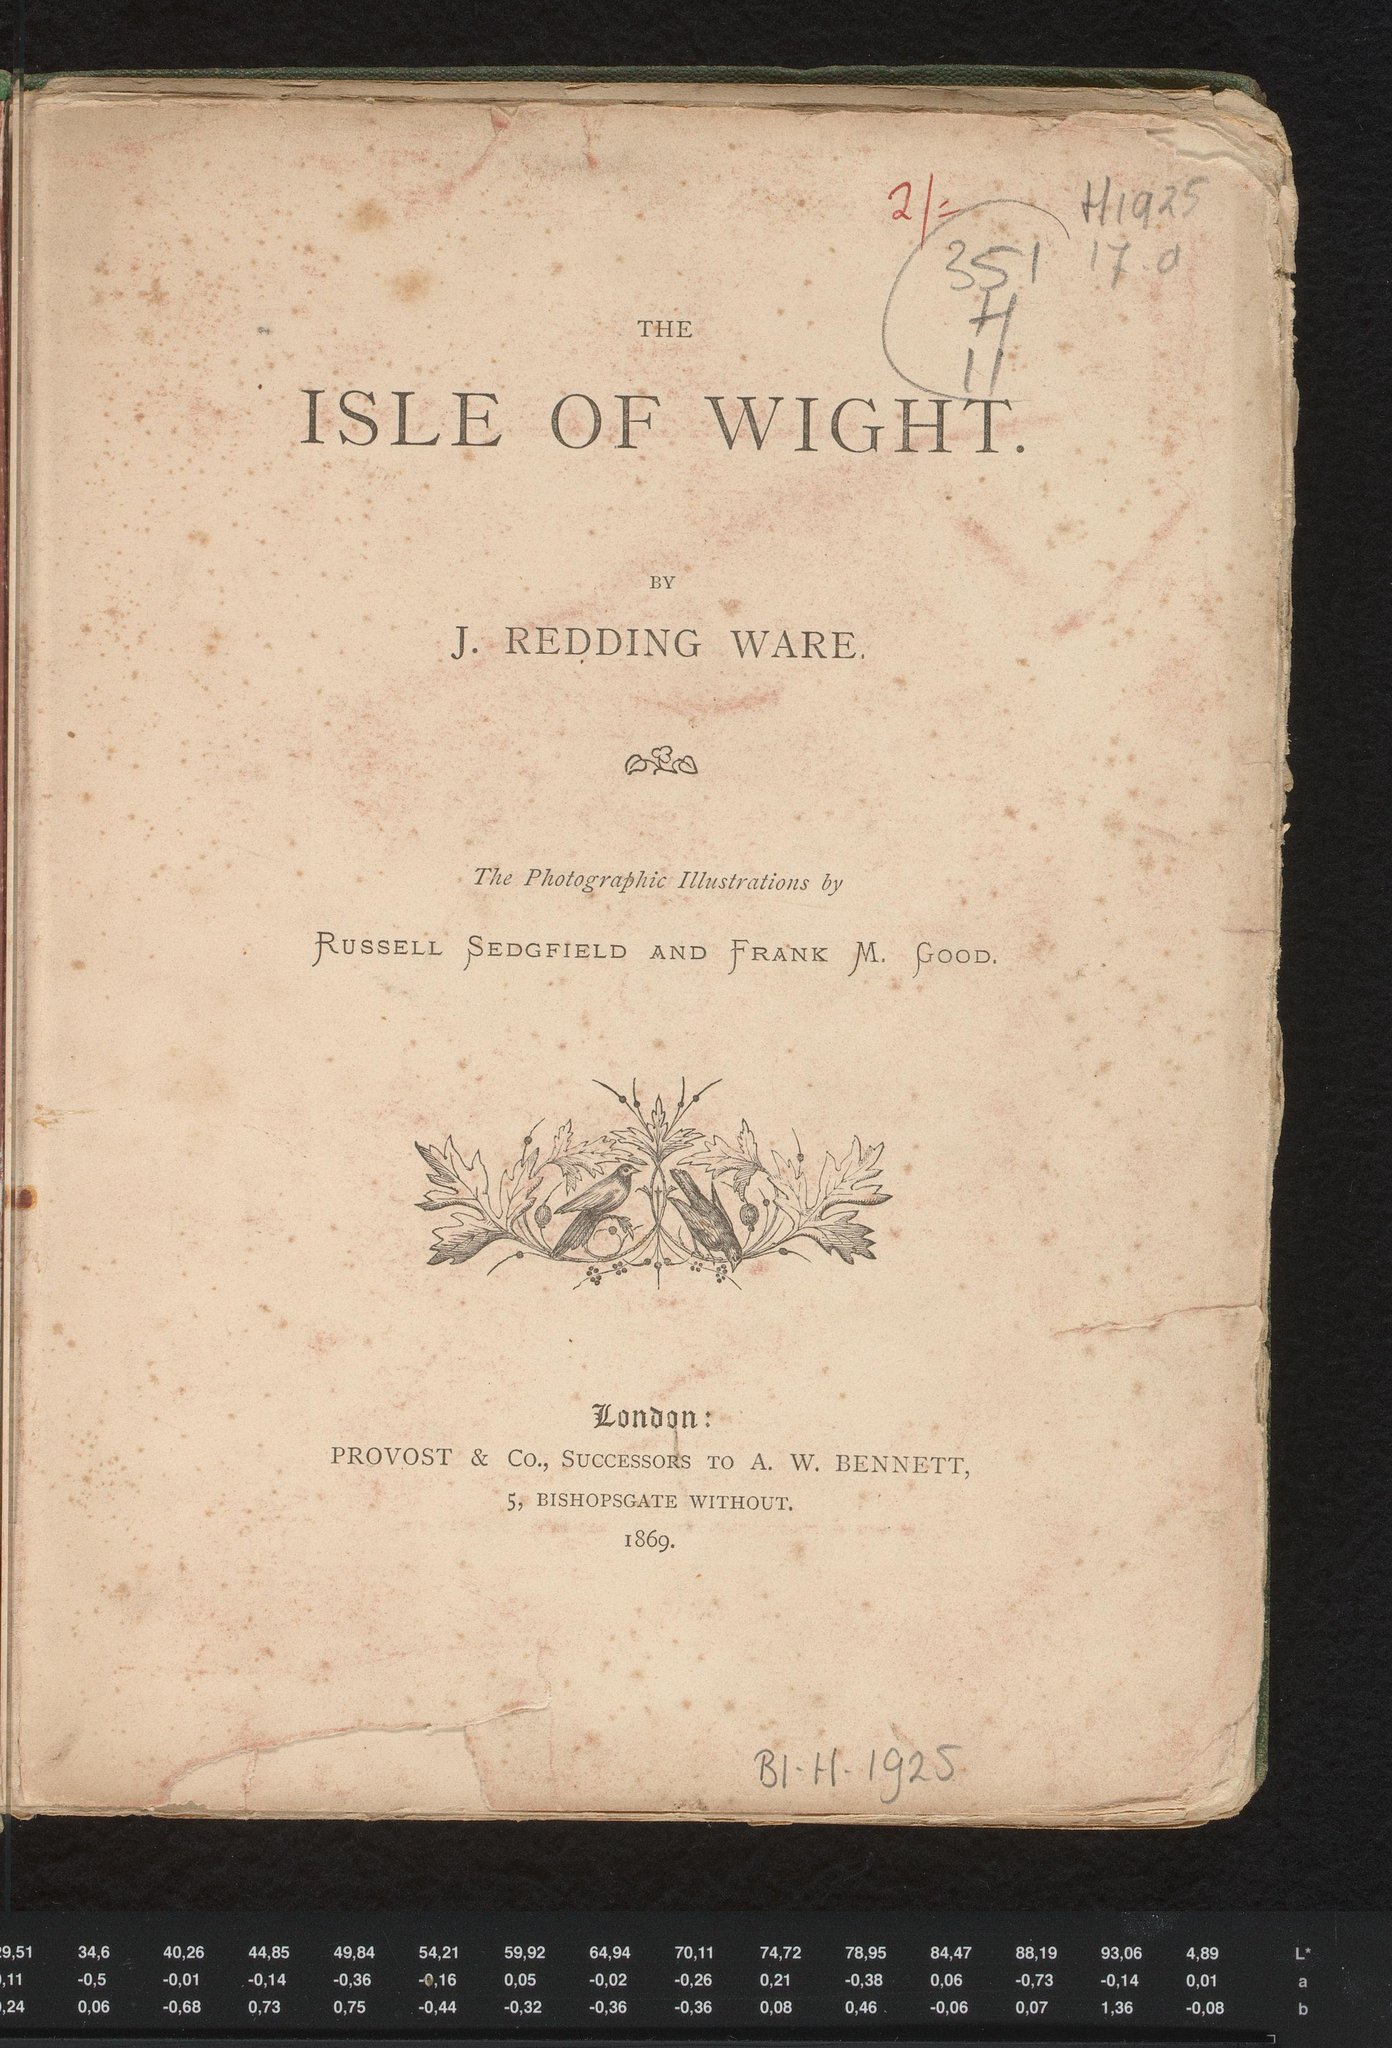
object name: book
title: The Isle of Wight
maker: james redding ware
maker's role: schrijver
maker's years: 1832-1909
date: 1869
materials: cardboard, linen, paper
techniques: albumen print, letterpress printing, printing block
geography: london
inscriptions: inscription: ‘2,=’